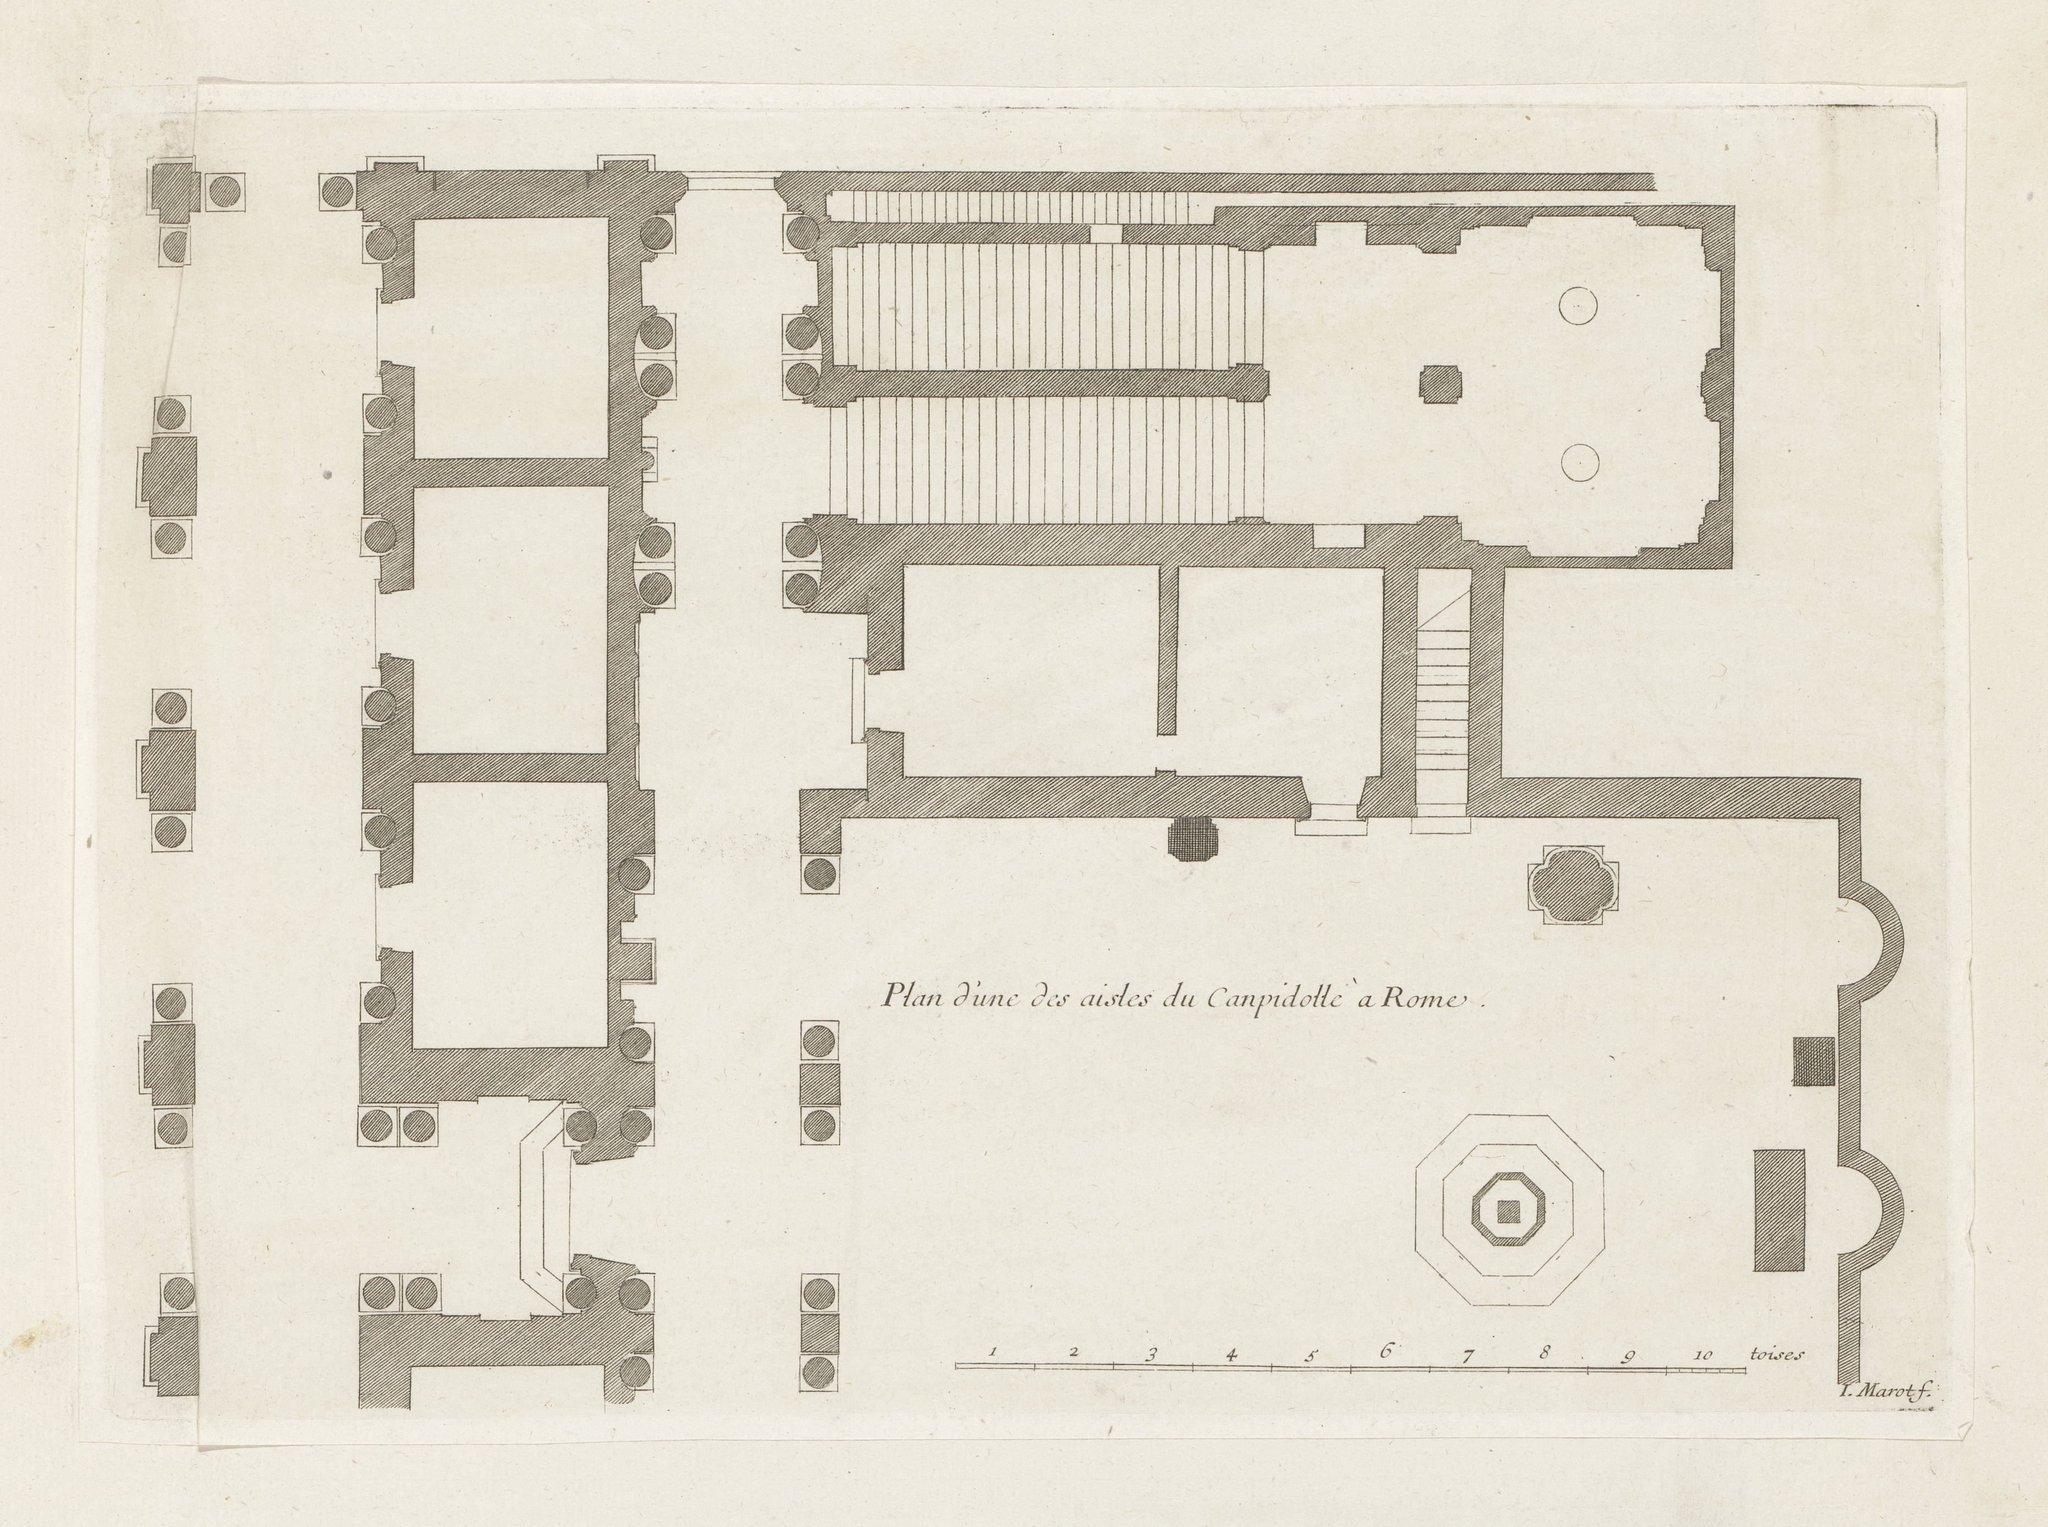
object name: album leaf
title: Magesyn der Italiaense gebouwen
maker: jean marot (i)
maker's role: print maker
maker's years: 1619-1679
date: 1629-1679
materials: paper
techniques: etching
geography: france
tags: plan ~ architecture